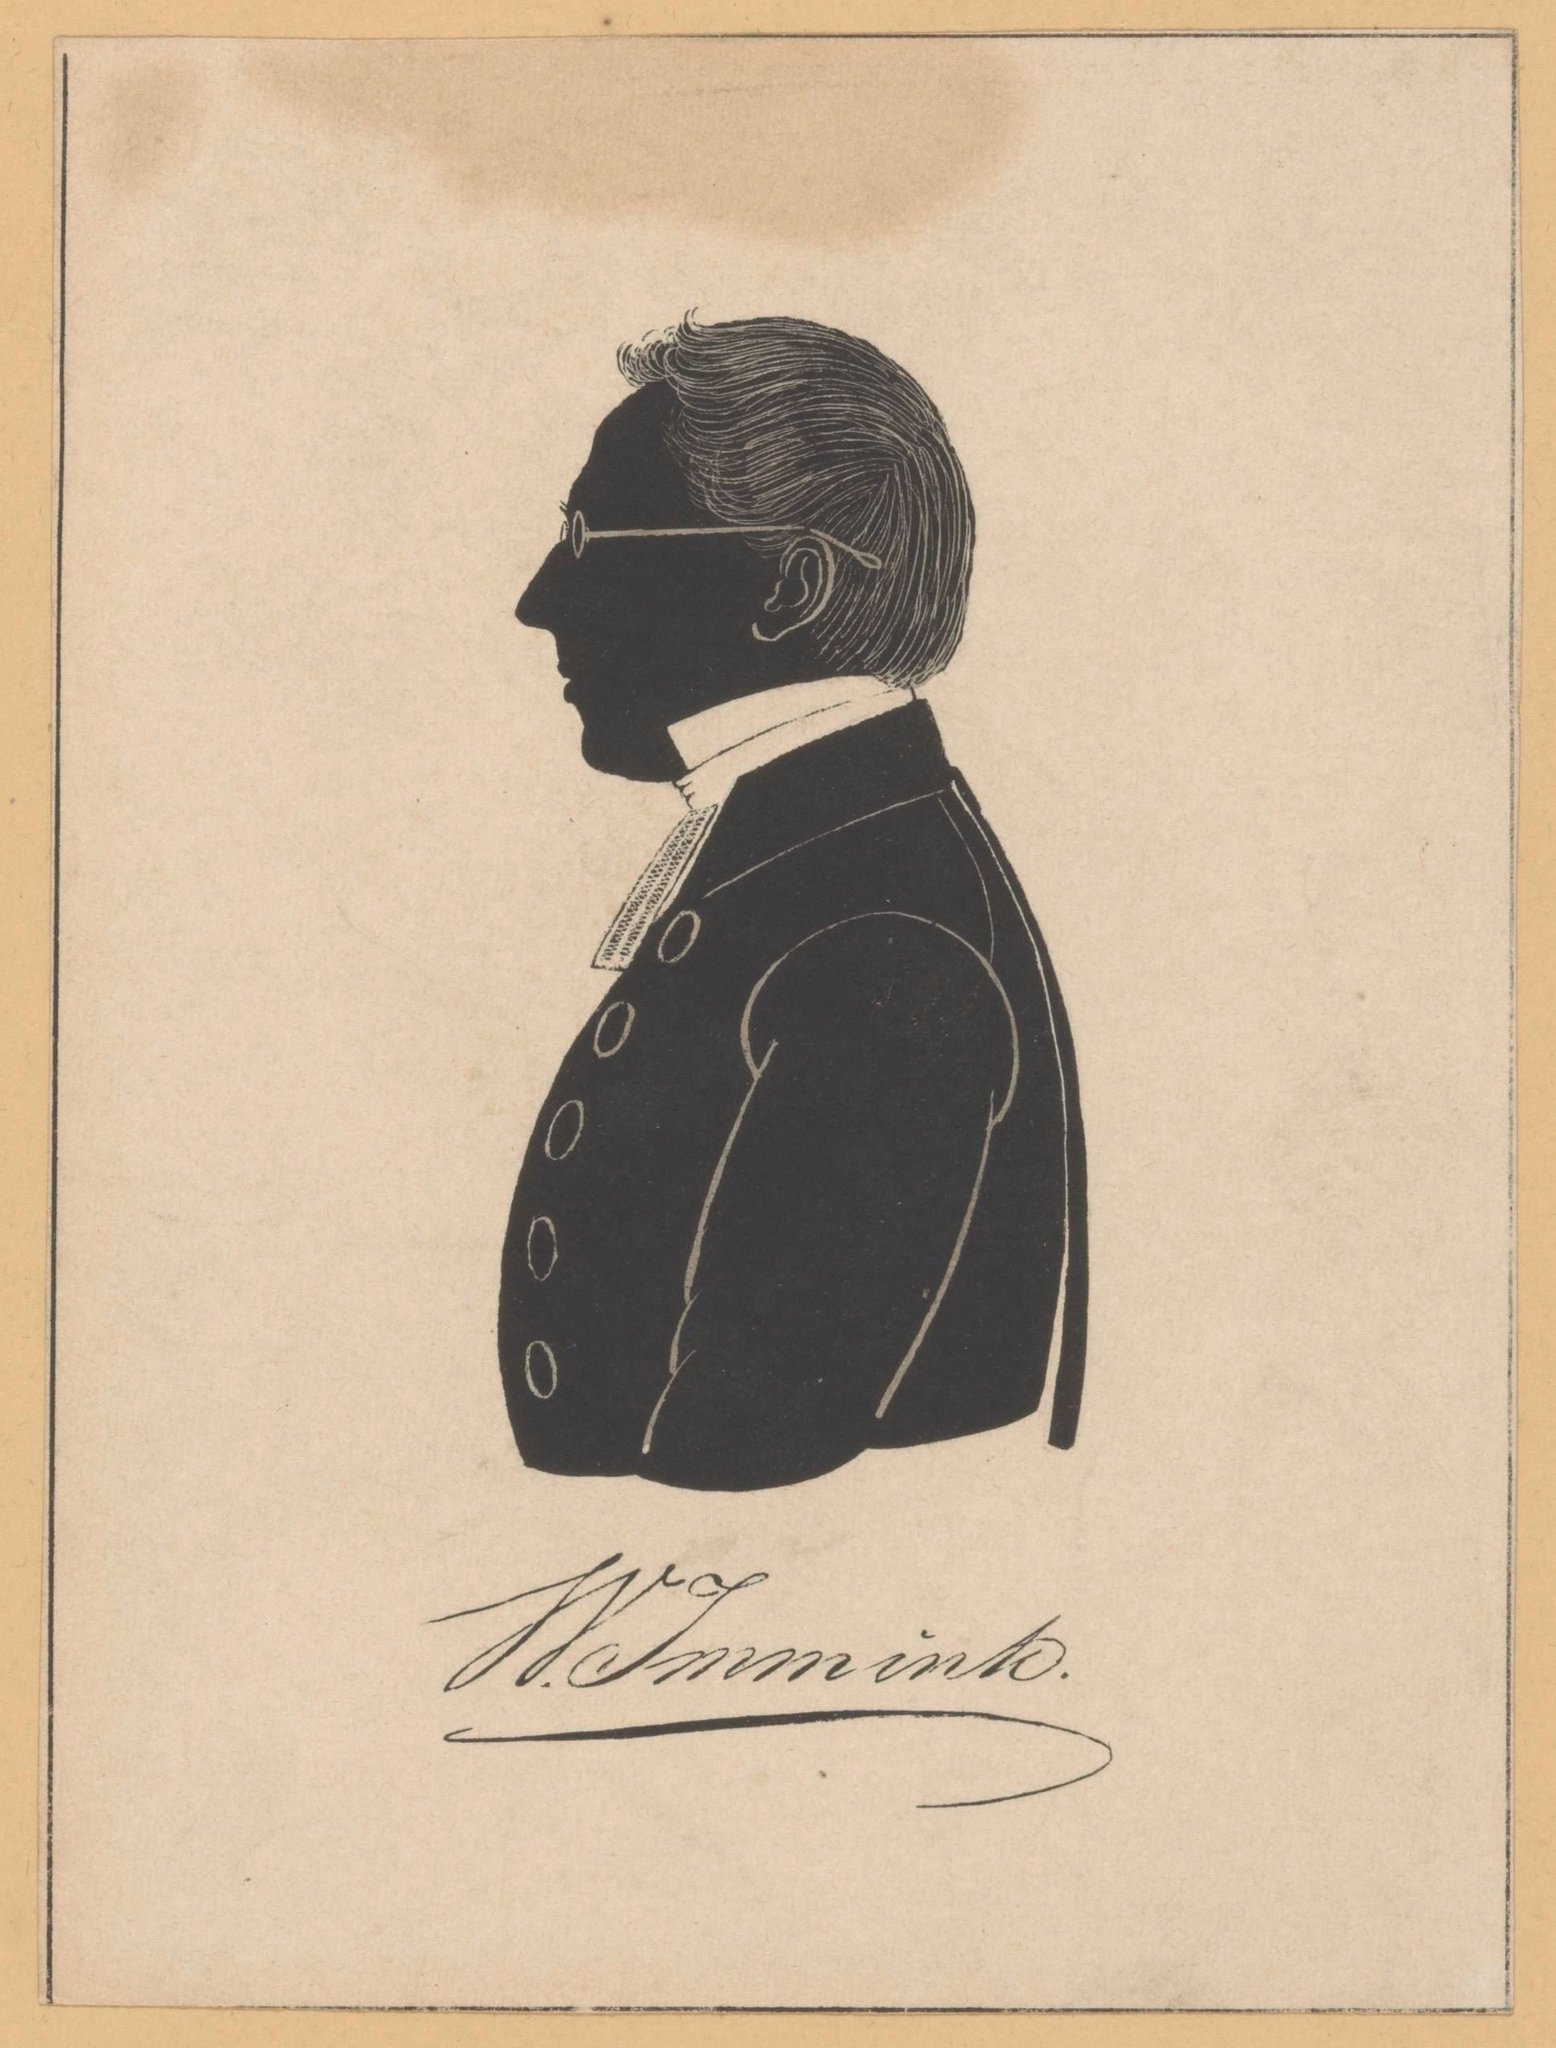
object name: print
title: Silhouetportret van W. Immink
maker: pieter barbiers (iv)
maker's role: painter, print maker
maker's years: 1798-1848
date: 1809-1848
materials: paper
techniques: hand coloring, lithograph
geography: netherlands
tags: historical persons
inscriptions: collector's mark: Lugt 2228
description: Onder het portret de signatuur van de geportretteerde.